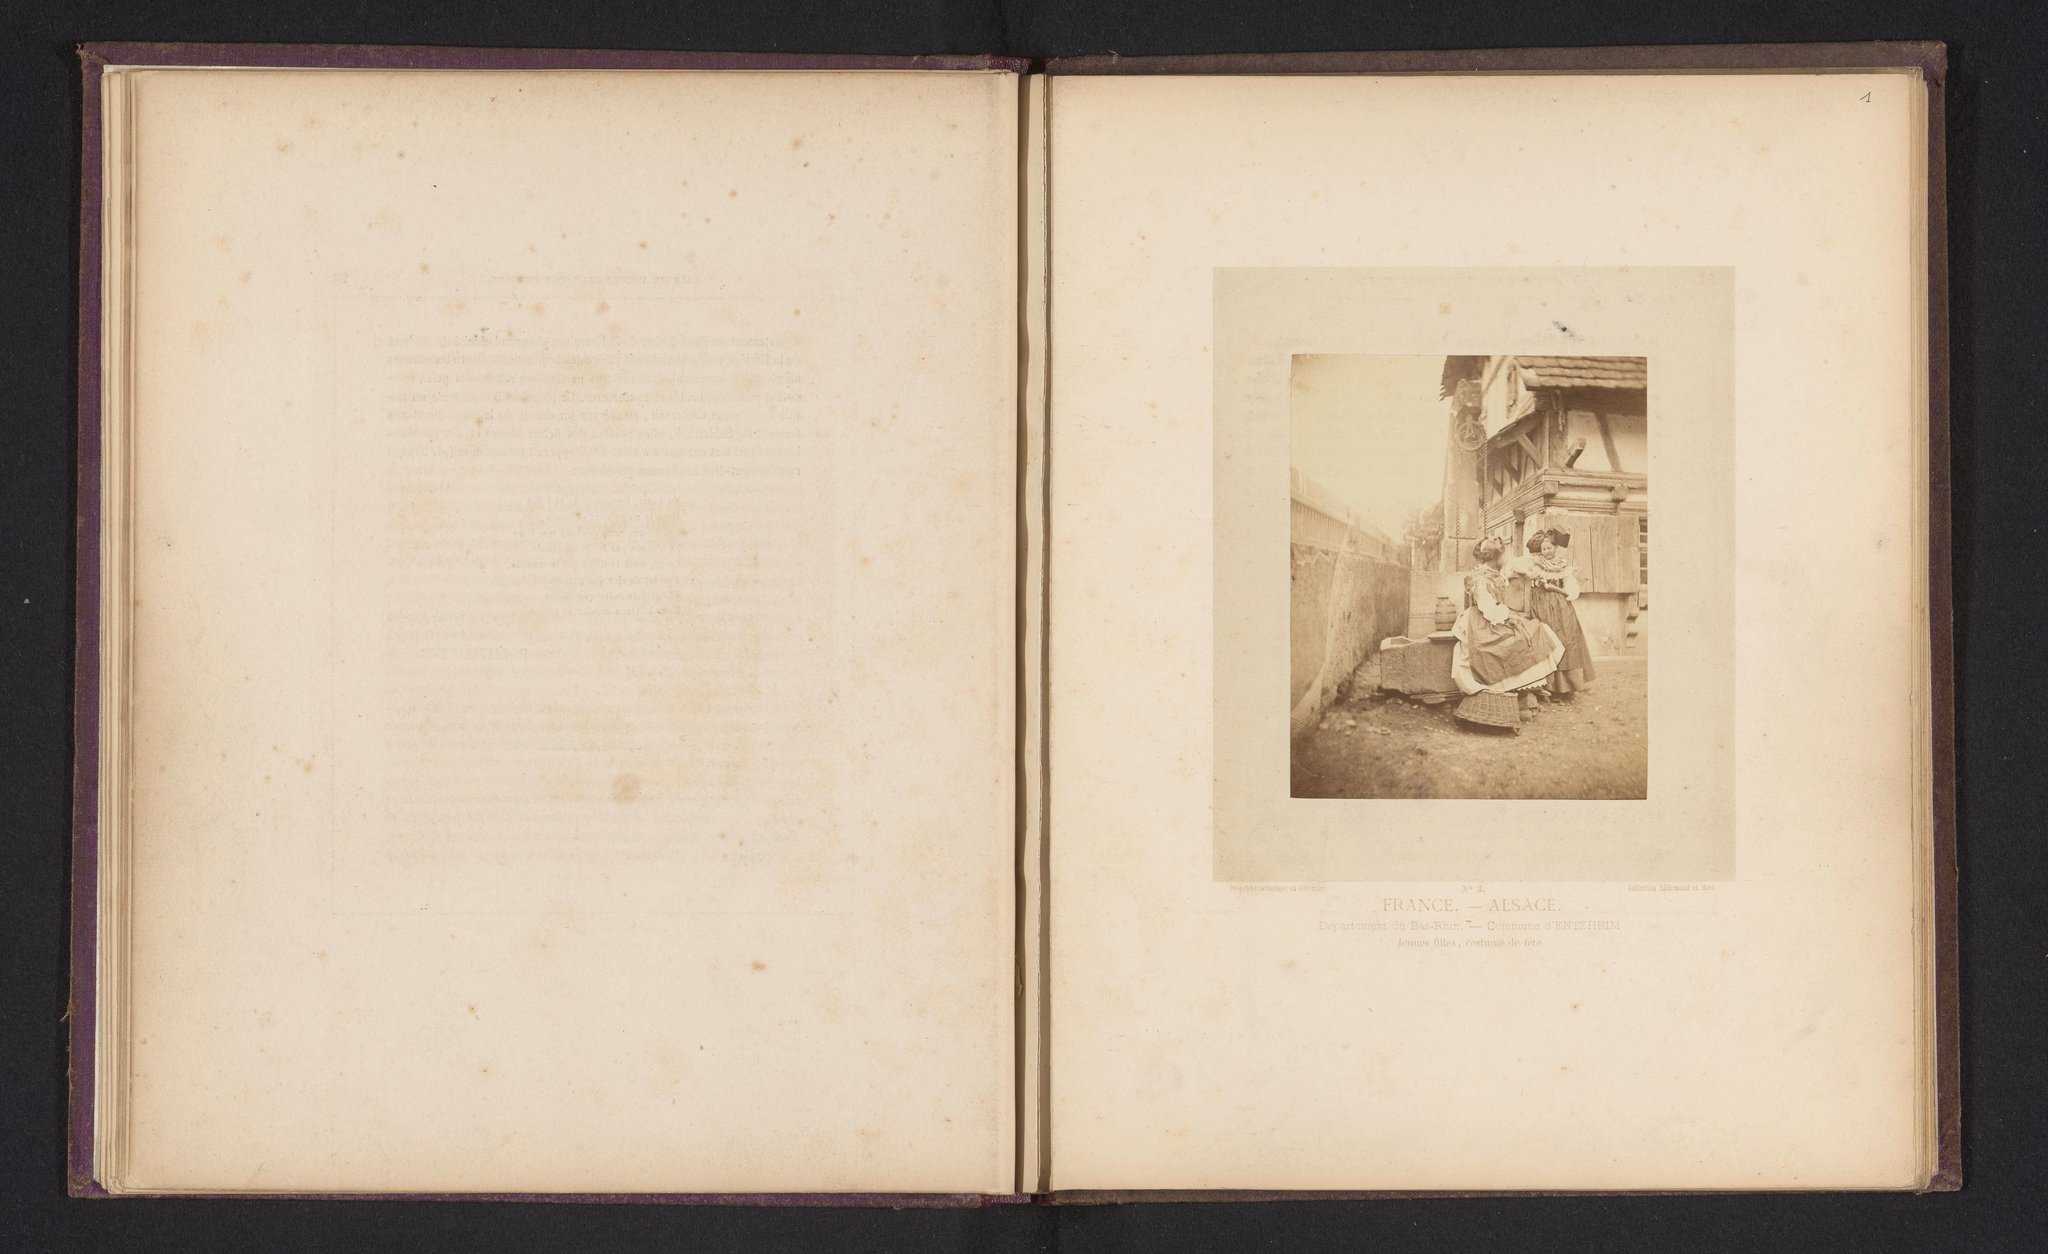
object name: page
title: Jeunes filles, costumes de fête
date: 1855-1865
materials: photographic support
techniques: albumen print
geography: entzheim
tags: adolescent, young woman, maiden, folk costume, regional costume, façade (of house or building)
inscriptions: number: ‘No. 2.’, number: ‘1’, inscription: ‘France. Alsace. Departement du Bas-Rhin.- Commune d'Entzheim’